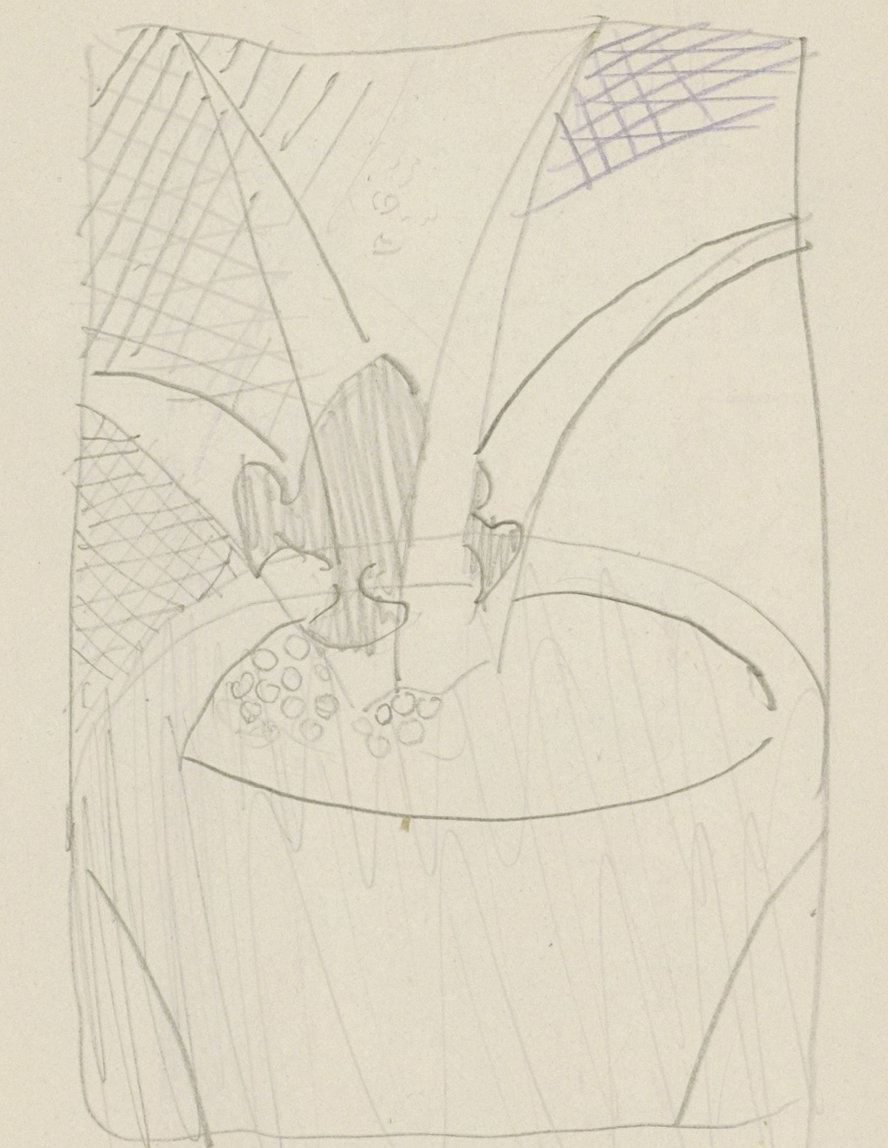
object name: sketchbook leaf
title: Plant in een pot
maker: reijer stolk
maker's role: draughtsman, print maker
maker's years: 1896-1945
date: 1906-1945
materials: paper, pencil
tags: plants and herbs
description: Blad 39 recto uit een schetsboek met 69 bladen.